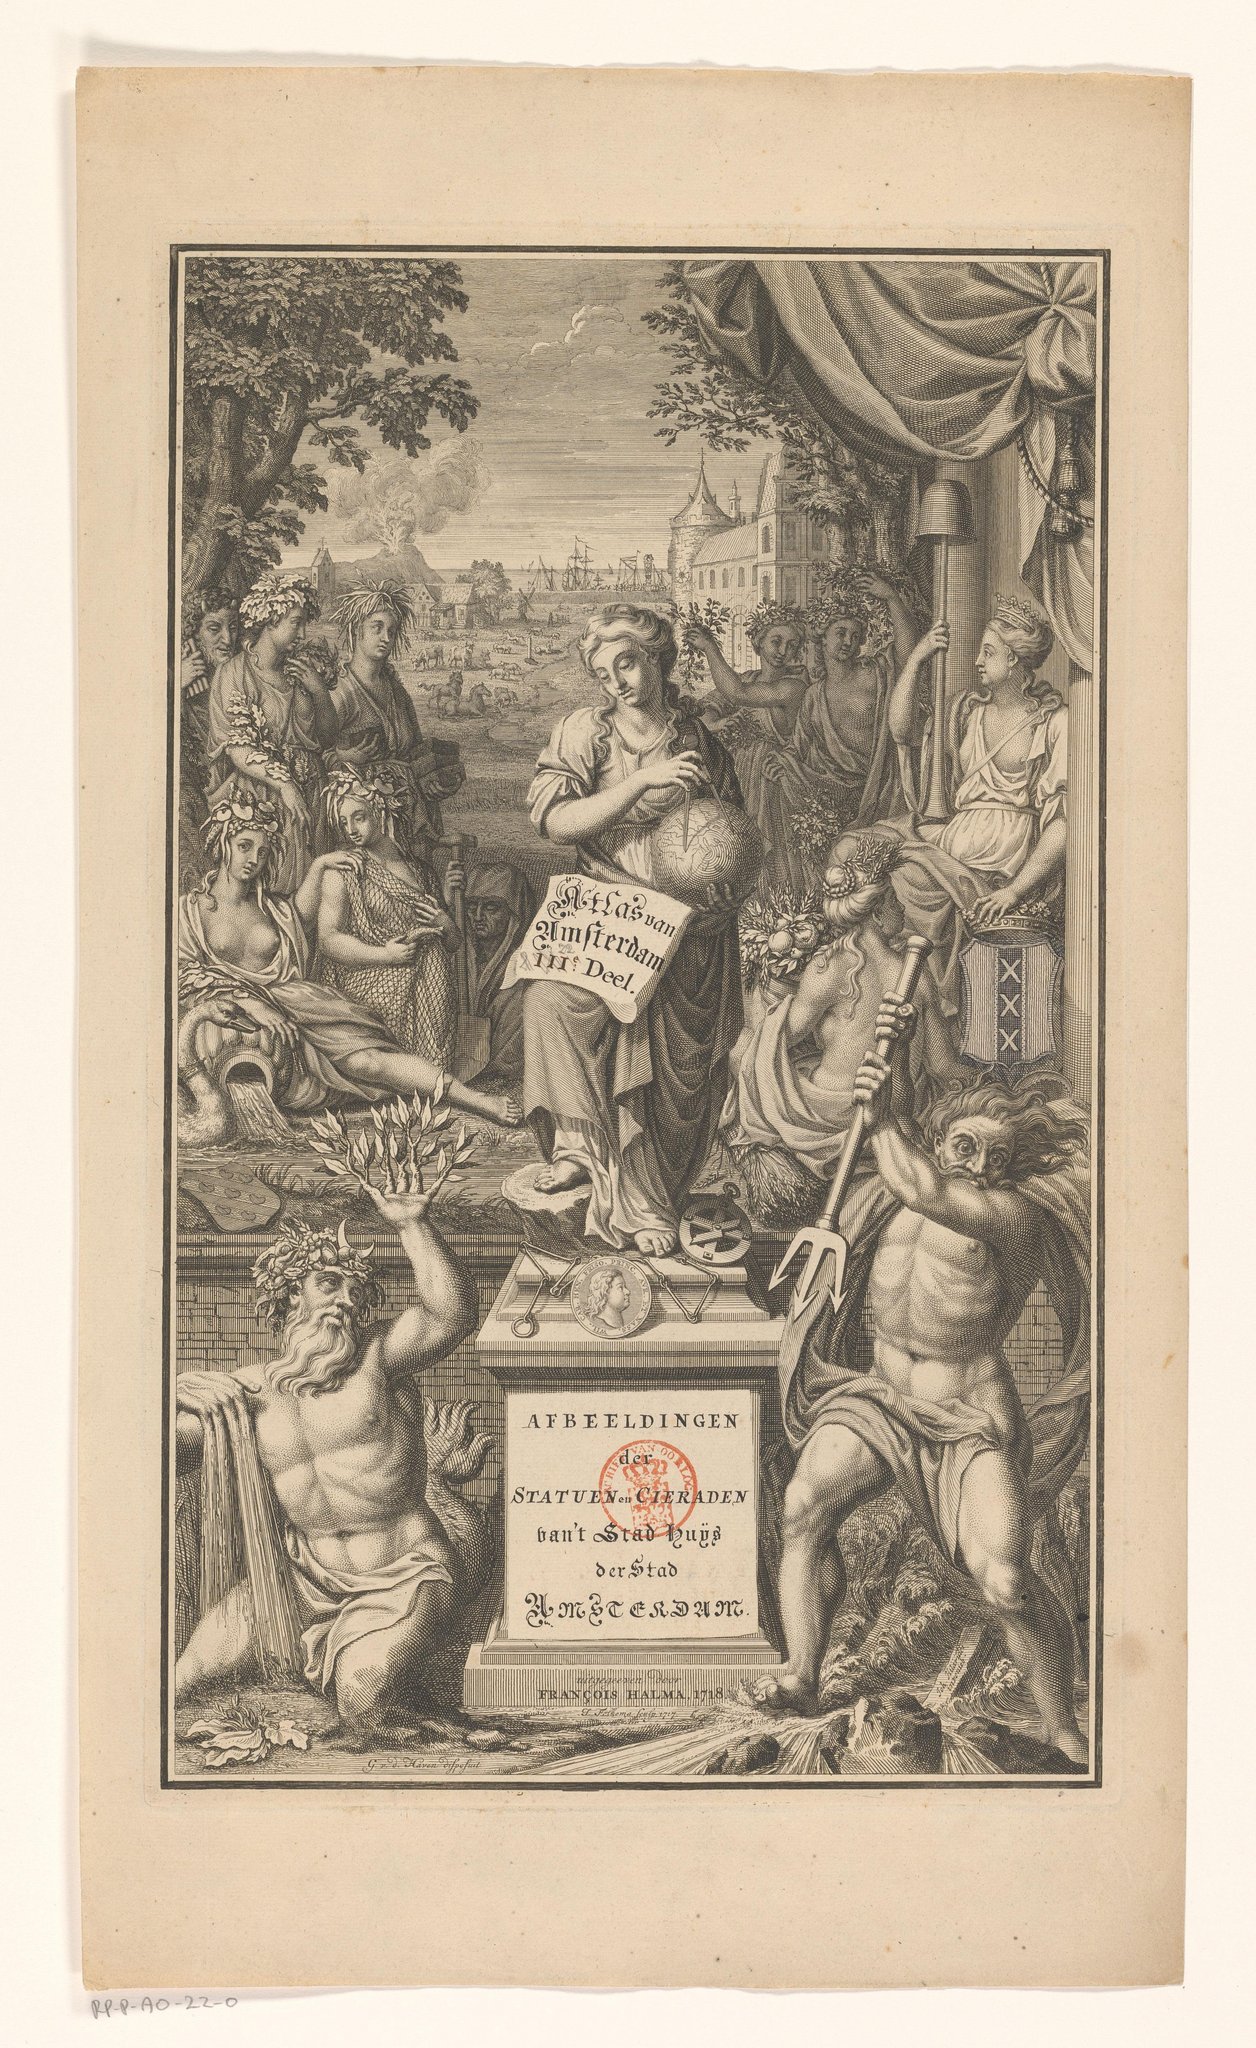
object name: print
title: Afbeeldingen der Statuen en Cieraden van't Stad Huijs der Stad Amsterdam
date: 1717-1718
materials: ink, paper, pencil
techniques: engraving, etching, pen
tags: commercial fishery, (story of) ceres (demeter), coat of arms (as symbol of the state, etc.) (+ city; municipal), peat-cutting, 'astronomia', 'cosmografia'; 'cosmografia' (ripa), personifications of countries, nations, states, districts, etc., river-gods, 'corografia', 'geografia', 'hidrografia' (ripa), agriculture, fruitfulness, productiveness, fertility, fecundity; 'fecondità' (ripa), (story of) flora, neptune as lord of the sea, amsterdam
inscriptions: collector's mark: Lugt 19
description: Deze prent is hier gebruikt als titelprent van een deel van een ongebonden atlas; een verzameling cartografische en topografische prenten en tekeningen. Oorspronkelijk was de prent echter bedoeld als titelpagina voor een gebonden atlas met kaarten van Friesland, waardoor een deel van de hier volgende beschrijving betrekking heeft op die context. Op het voetstuk in het midden staat de personificatie van de cartografie, met in haar hand een aardbol die ze met een passer meet. Op haar bovenbeen rust een blad met het handgeschreven deel van de atlas (oorspronkelijk een kaart van Friesland). Aan haar voeten een meetketting, een rond (land)meetkundig instrument en een portret van Willem IV van Oranje-Nassau. Daaronder de handgeschreven titel van dit deel van de atlas. Ze houdt een wakend oog op Wispelturigheid (Wispeltuer), linksonder. Oorspronkelijk staat hij voor de wispelturigheid waar het Friese land zich naar moest schikken: een bos kon opeens onder water staan, want zijn lichaam smelt door het zoute water van de zee. Linksboven zijn hoofd een wapenschild met het wapen van Friesland (met schuinbalken en pompeblêden). De dreiging van de zee is rechtsonder verbeeld door een onstuimige Neptunus (Zeevoogd). Links en rechts van Cartografie nog meer figuren die oorspronkelijk betrekking hadden op Friesland en haar vruchtbare natuur, visserij en landbouw. Links, met haar arm leunend op een kruik waar water uitstroomt, een stroomgodin (Stroomvoogdess) met rechts van haar de personificatie van de visserij (Visschevang). Boven hen van links naar rechts: een sater met fluit als personificatie van de natuur (Natuer), de personificatie van de bossen met eikenloven (Woudman) en personificatie van de turfwinning (vrouw Veenbrand). Rechtsonder haar vrouw Onland, die rouwt om de schade die de turfwinning aan het land veroorzaakt. Rechts van Cartografie zit Flora en/of Ceres (vrouw Veldgewas) met korenaren en cornucopia, ze staat voor de overvloed die voortvloeit uit het land. Boven haar, op de achtergrond, twee vrouwelijke personificaties die in verband staan met groene weides en/of grasvelden: Beemdeheil en Graazevol. Rechts, met in haar ene hand een bazuin met daarop een vrijheidshoed en in de andere hand een schild met het wapen van Amsterdam, de personificatie van het gebied van dit deel van de atlas (oorspronkelijk de Friese Maagd met het provinciewapen met twee leeuwen). Op de achtergrond een landschap met kenmerkende Friese elementen, zoals het Sjaerdemaslot te Franeker en de vuurspuwende Rode Klif te Gaasterland (zou in de oudheid een vulkaan zijn geweest).